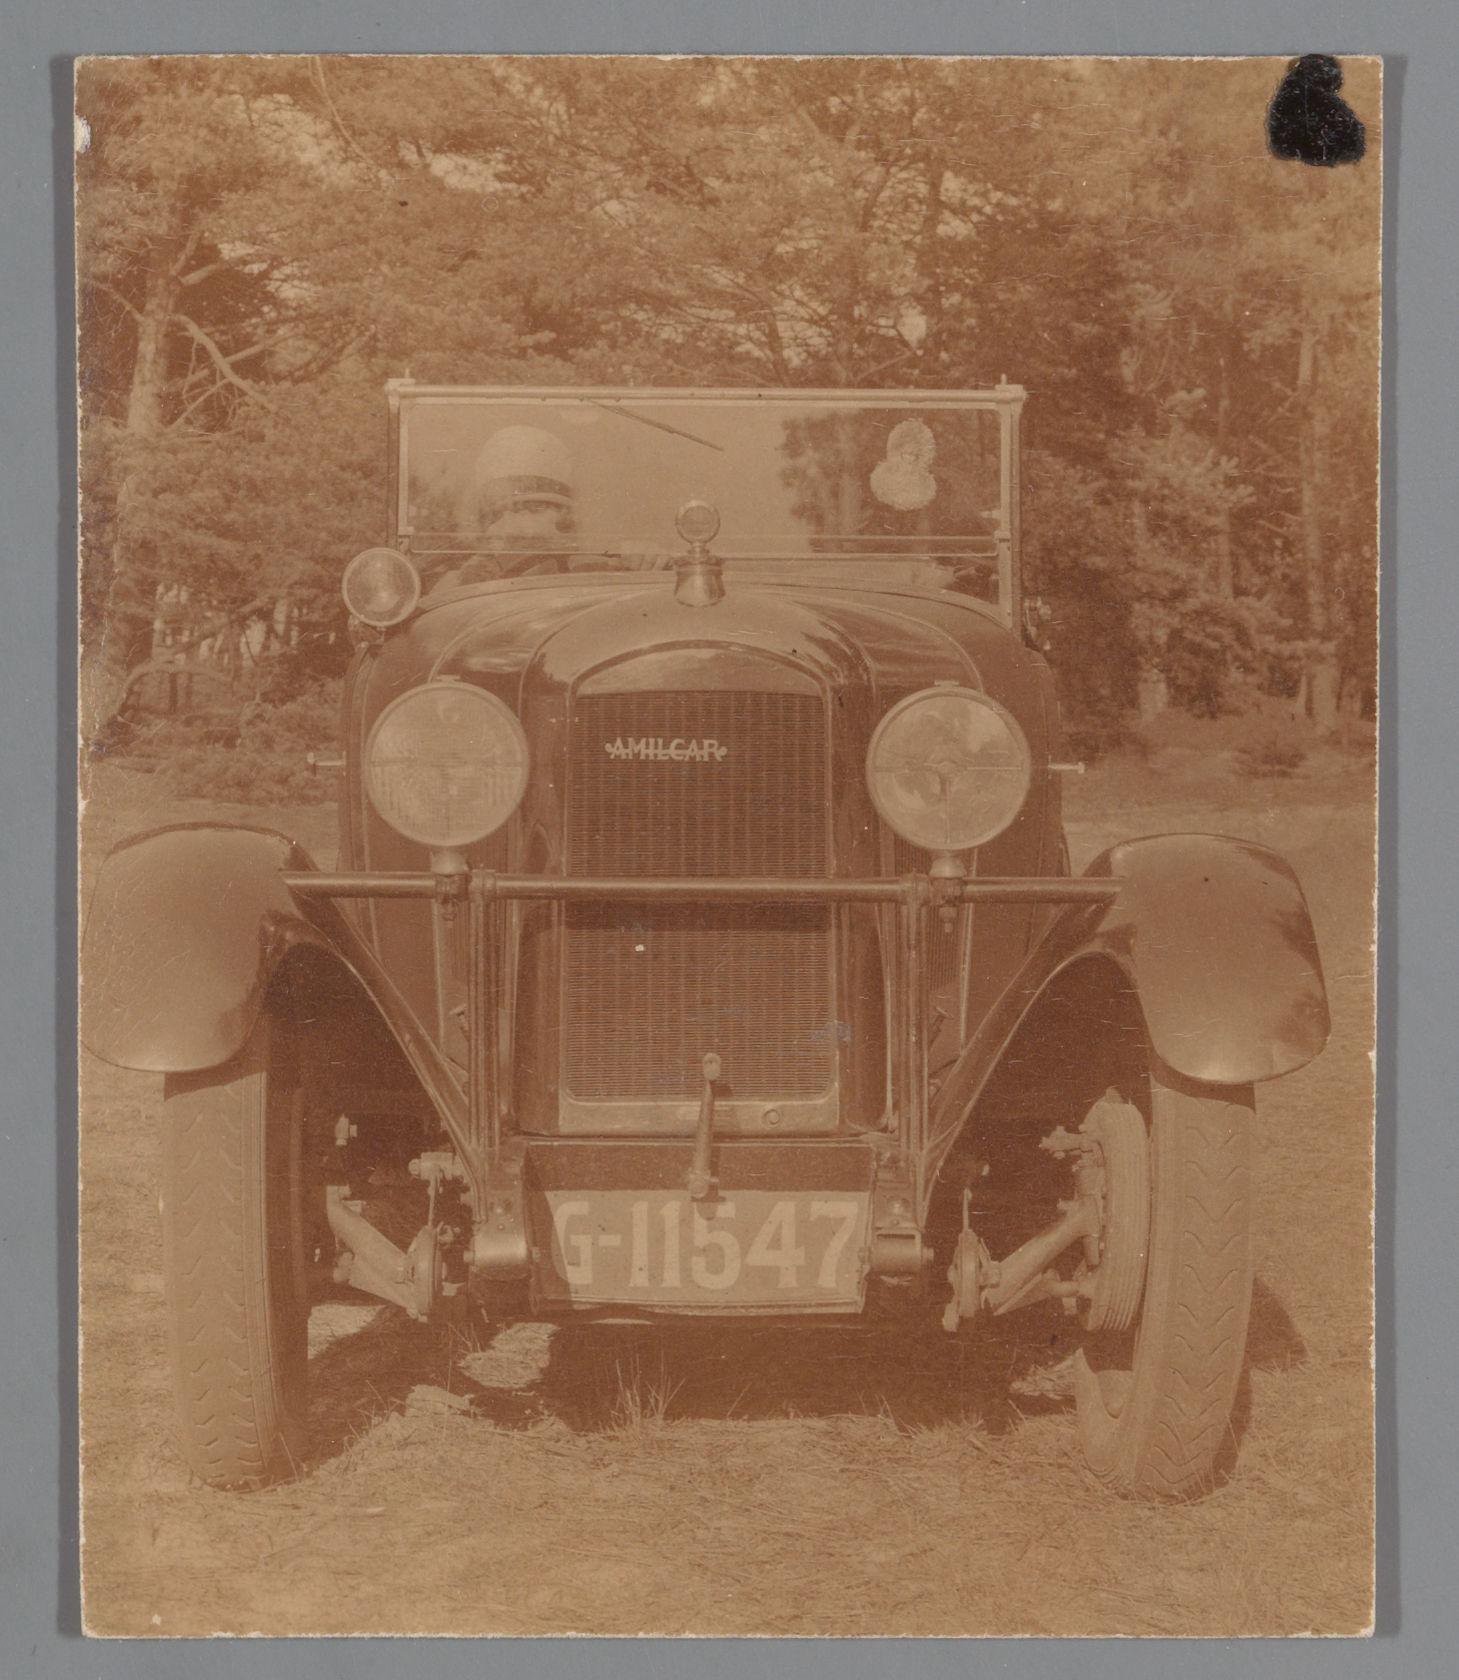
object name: photograph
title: Onbekende vrouw in een auto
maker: Anonymous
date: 1926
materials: photographic support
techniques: gelatin silver print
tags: adult woman, automobile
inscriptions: inscription: ‘1926’